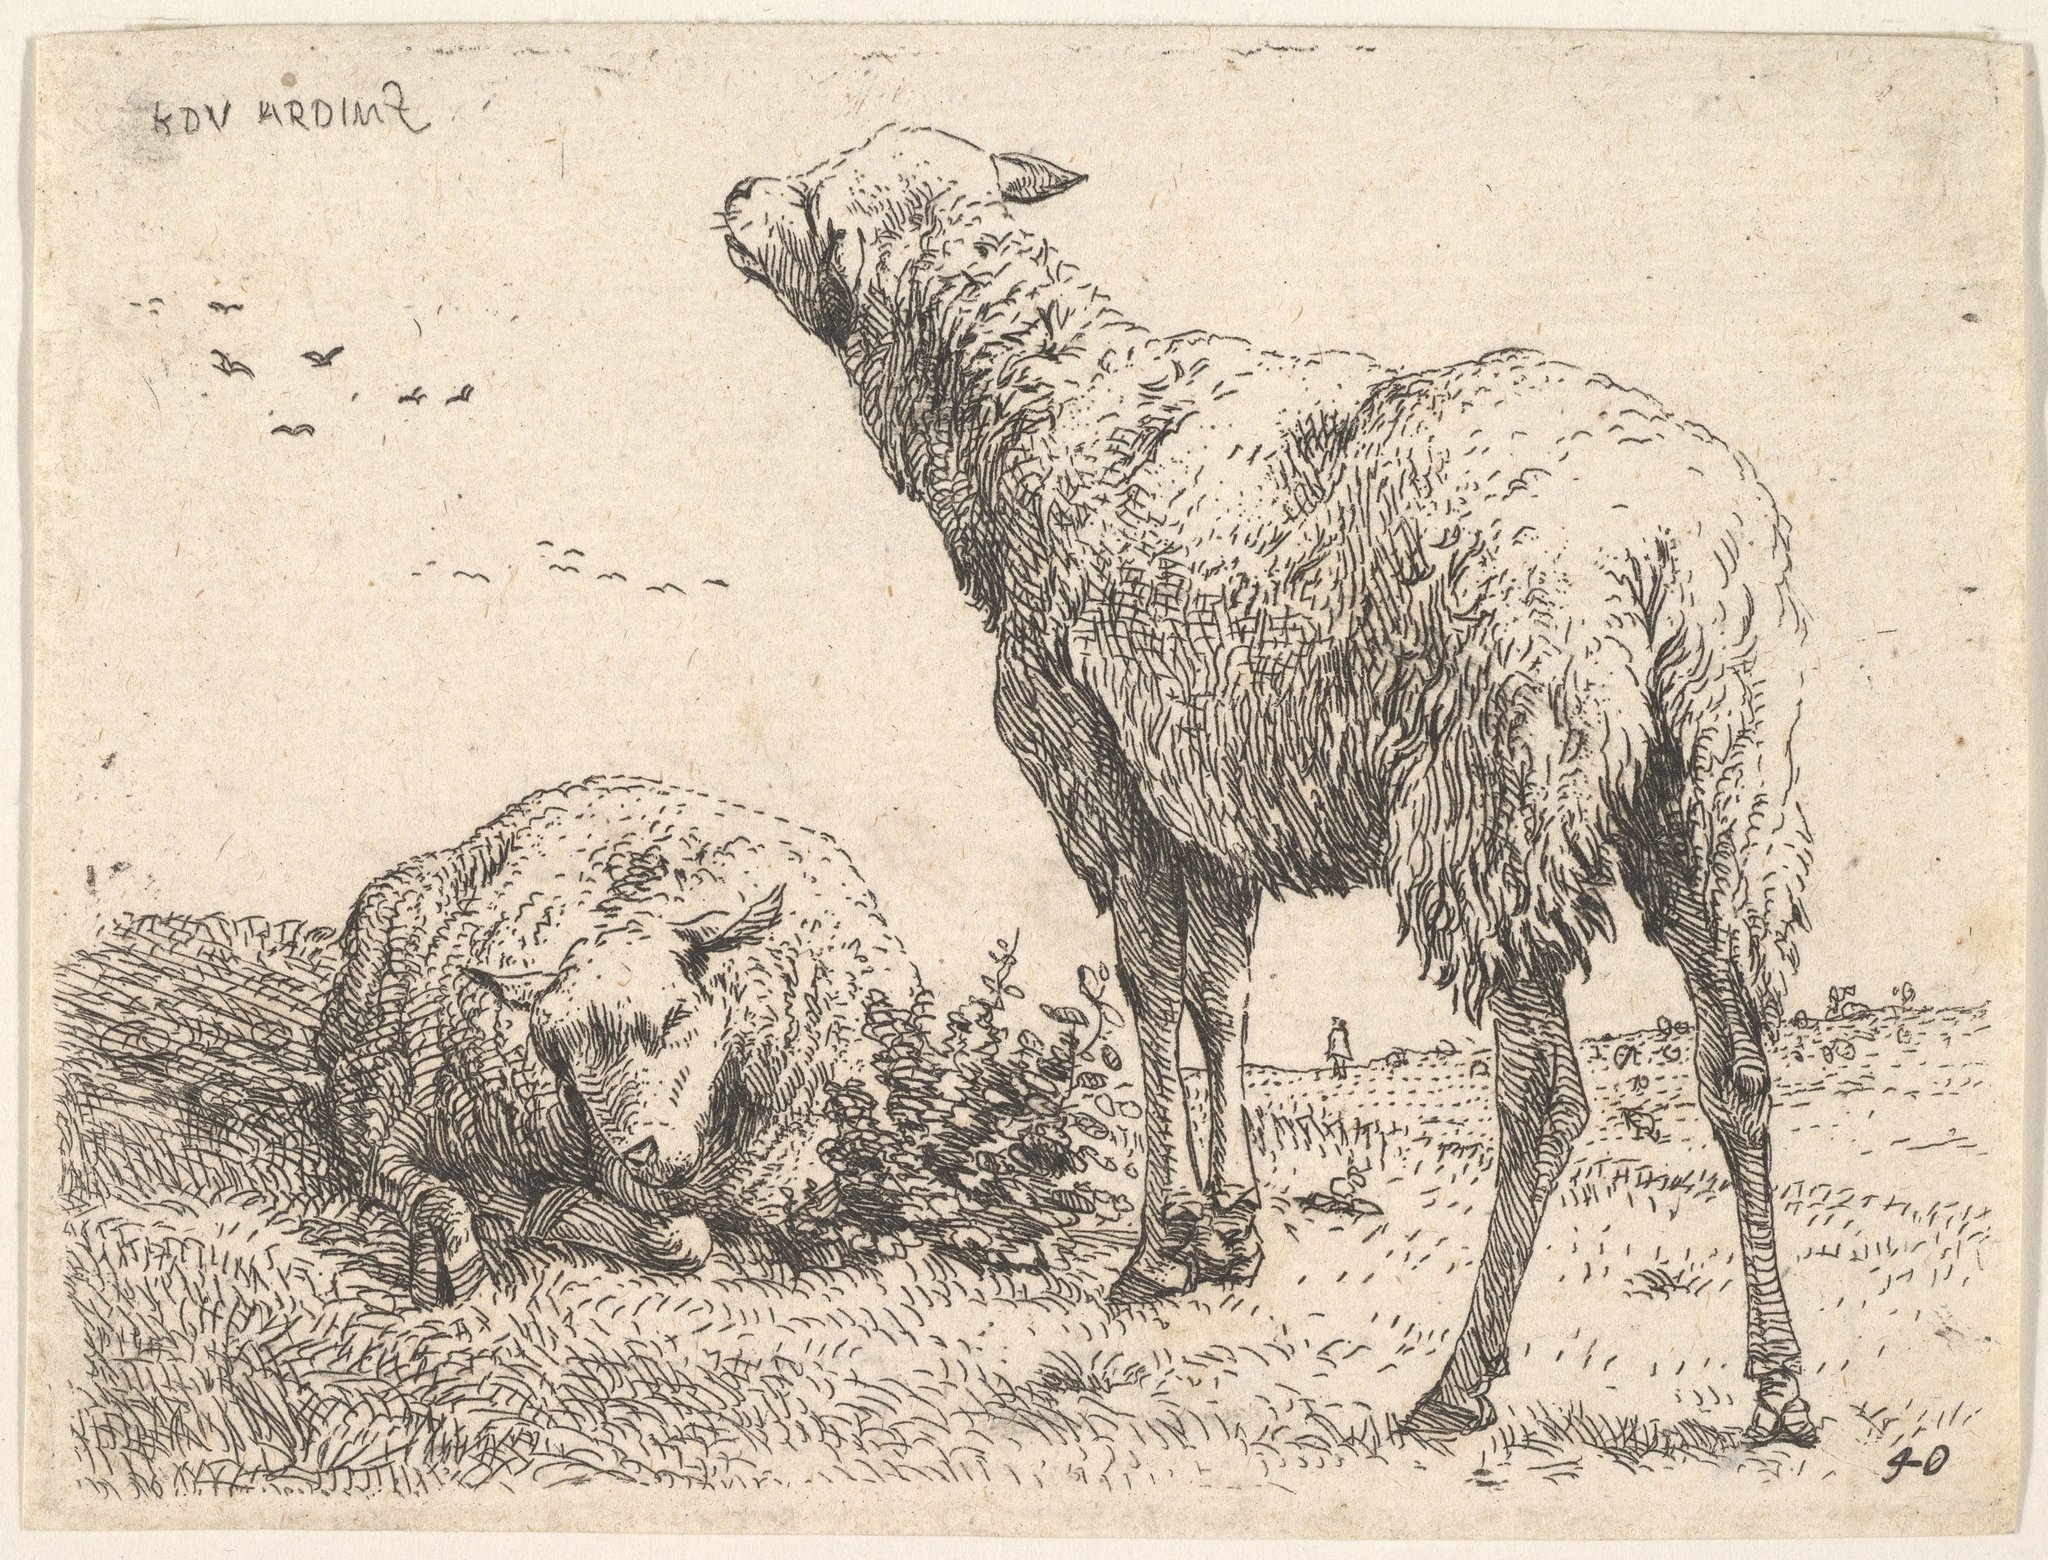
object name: print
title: Two sheep, one shown frontally in a reclining position with its legs folded underneath the body, to the right a standing sheep shown from behind in three-quarters view, a grassy field below them and beyond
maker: karel dujardin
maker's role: artist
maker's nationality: dutch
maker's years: 1622-1678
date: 1655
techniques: etching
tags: sheep